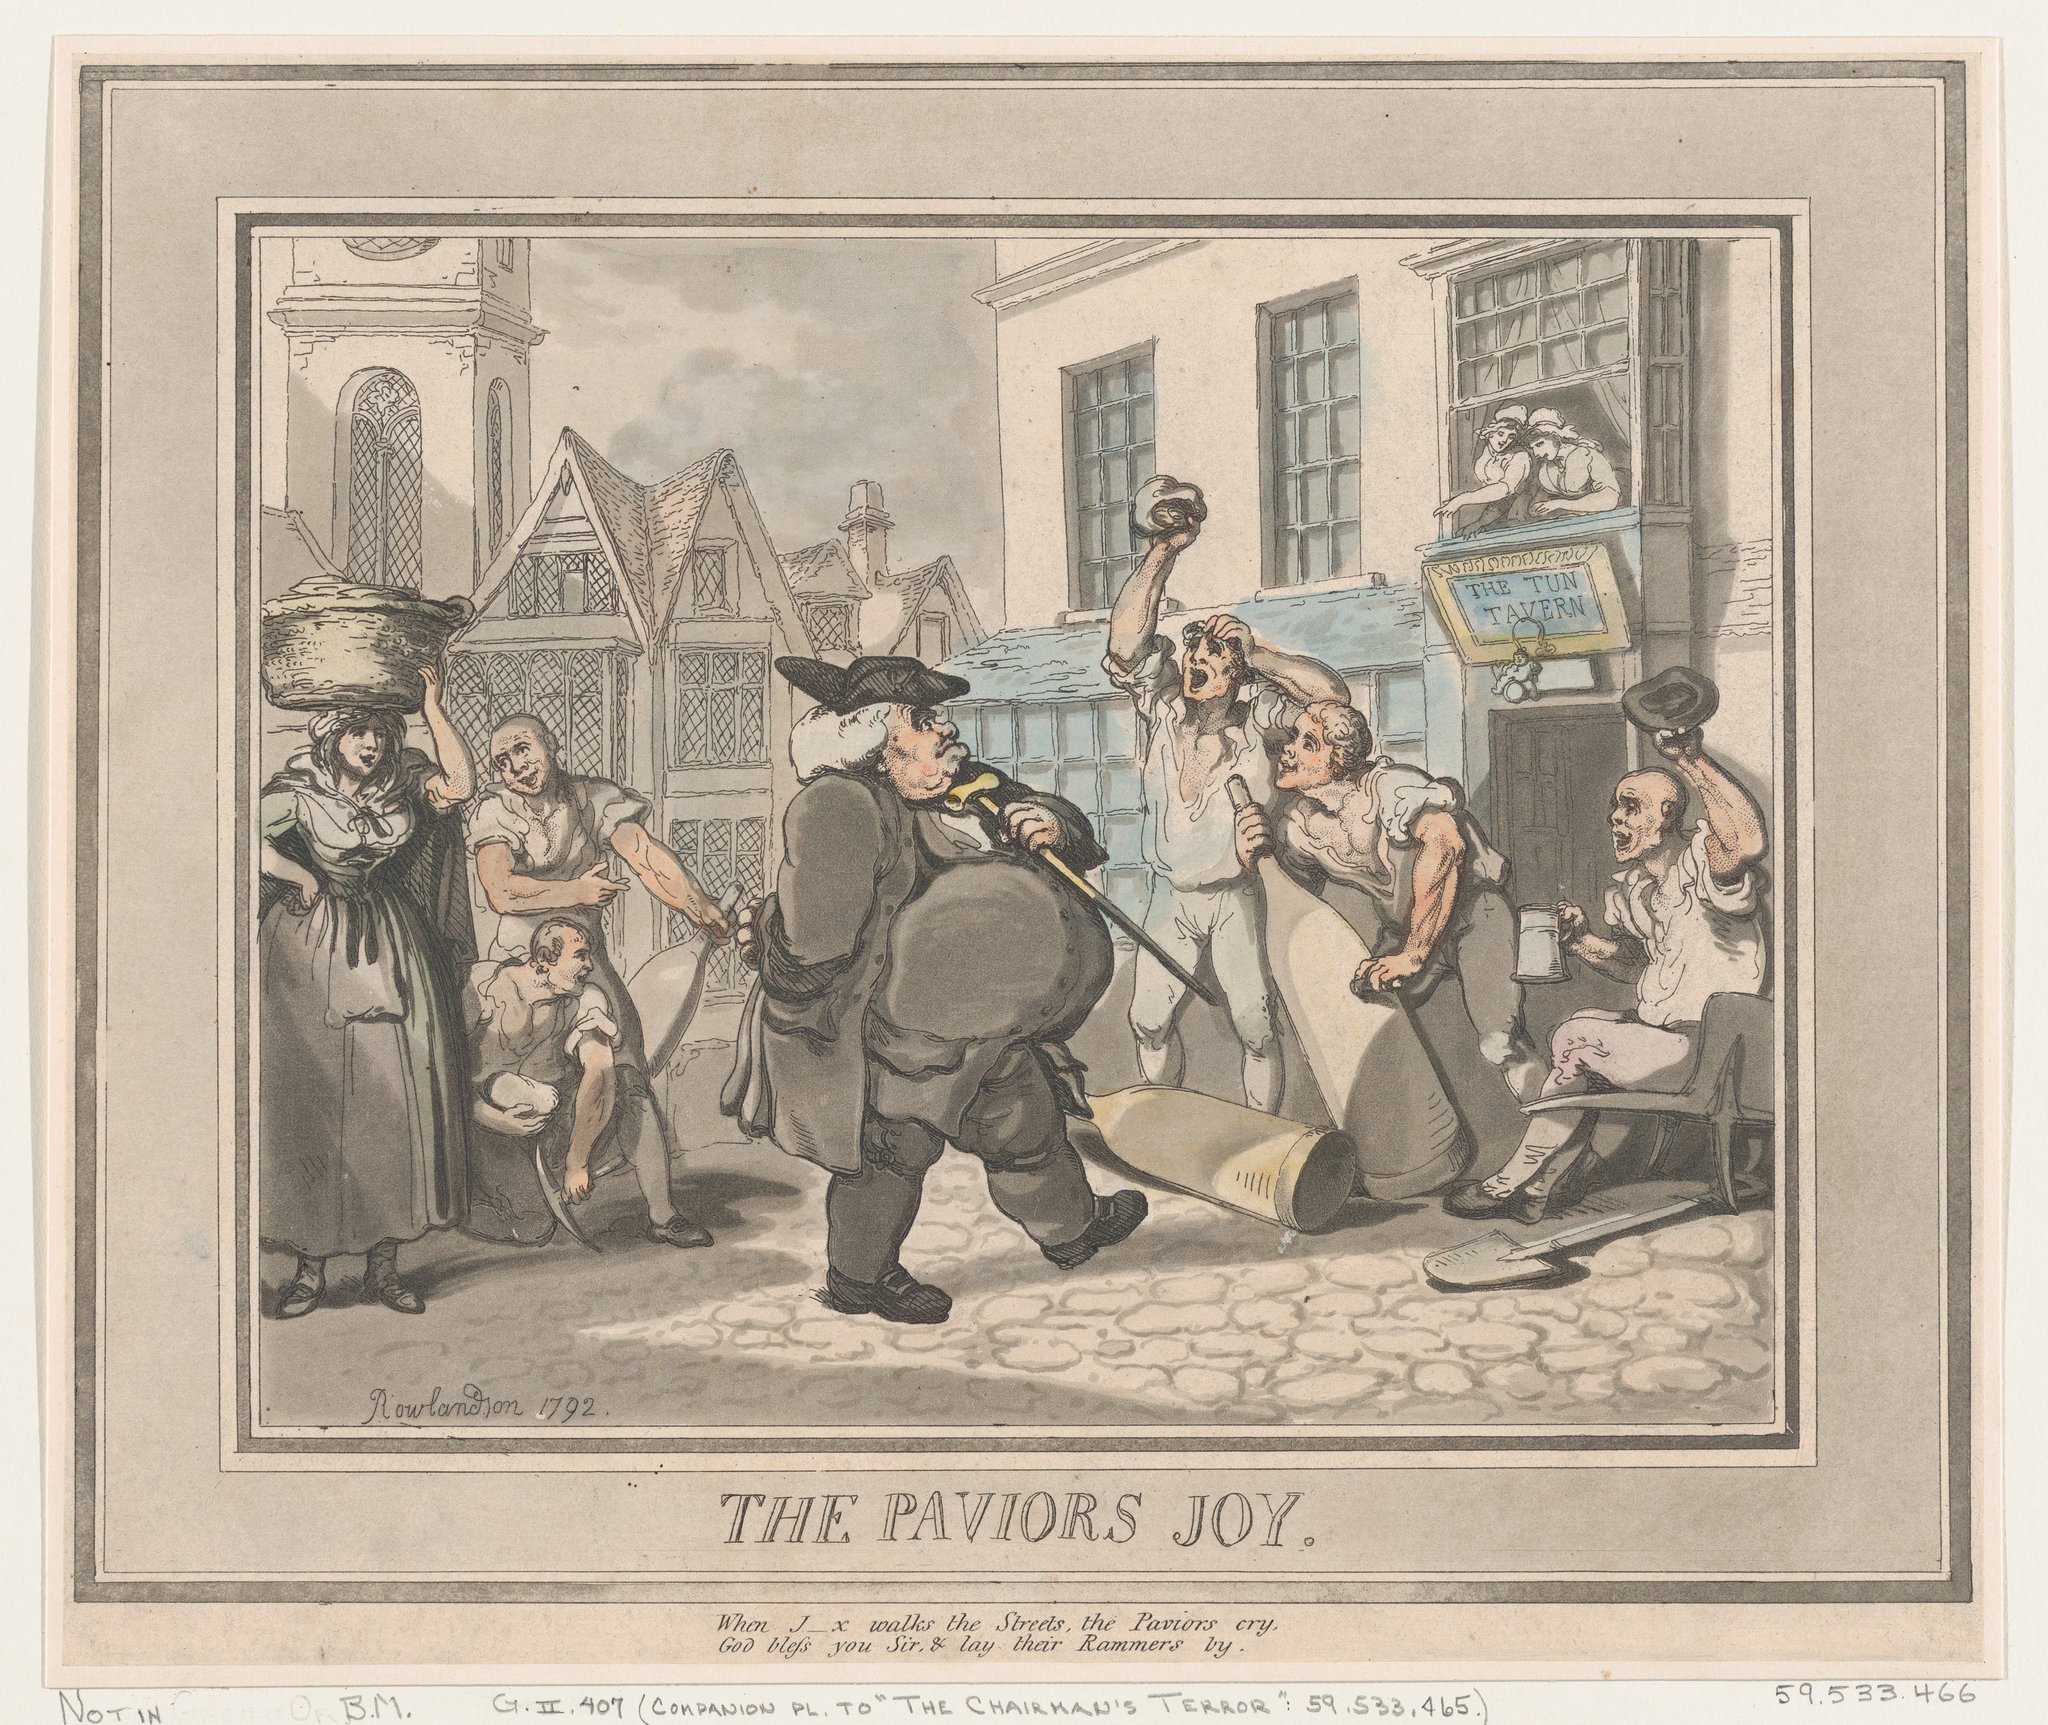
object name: print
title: The Pavior's Joy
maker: thomas rowlandson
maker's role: artist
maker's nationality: british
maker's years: 1757-1827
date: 1792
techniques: aquatint, etching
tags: satire,men,women